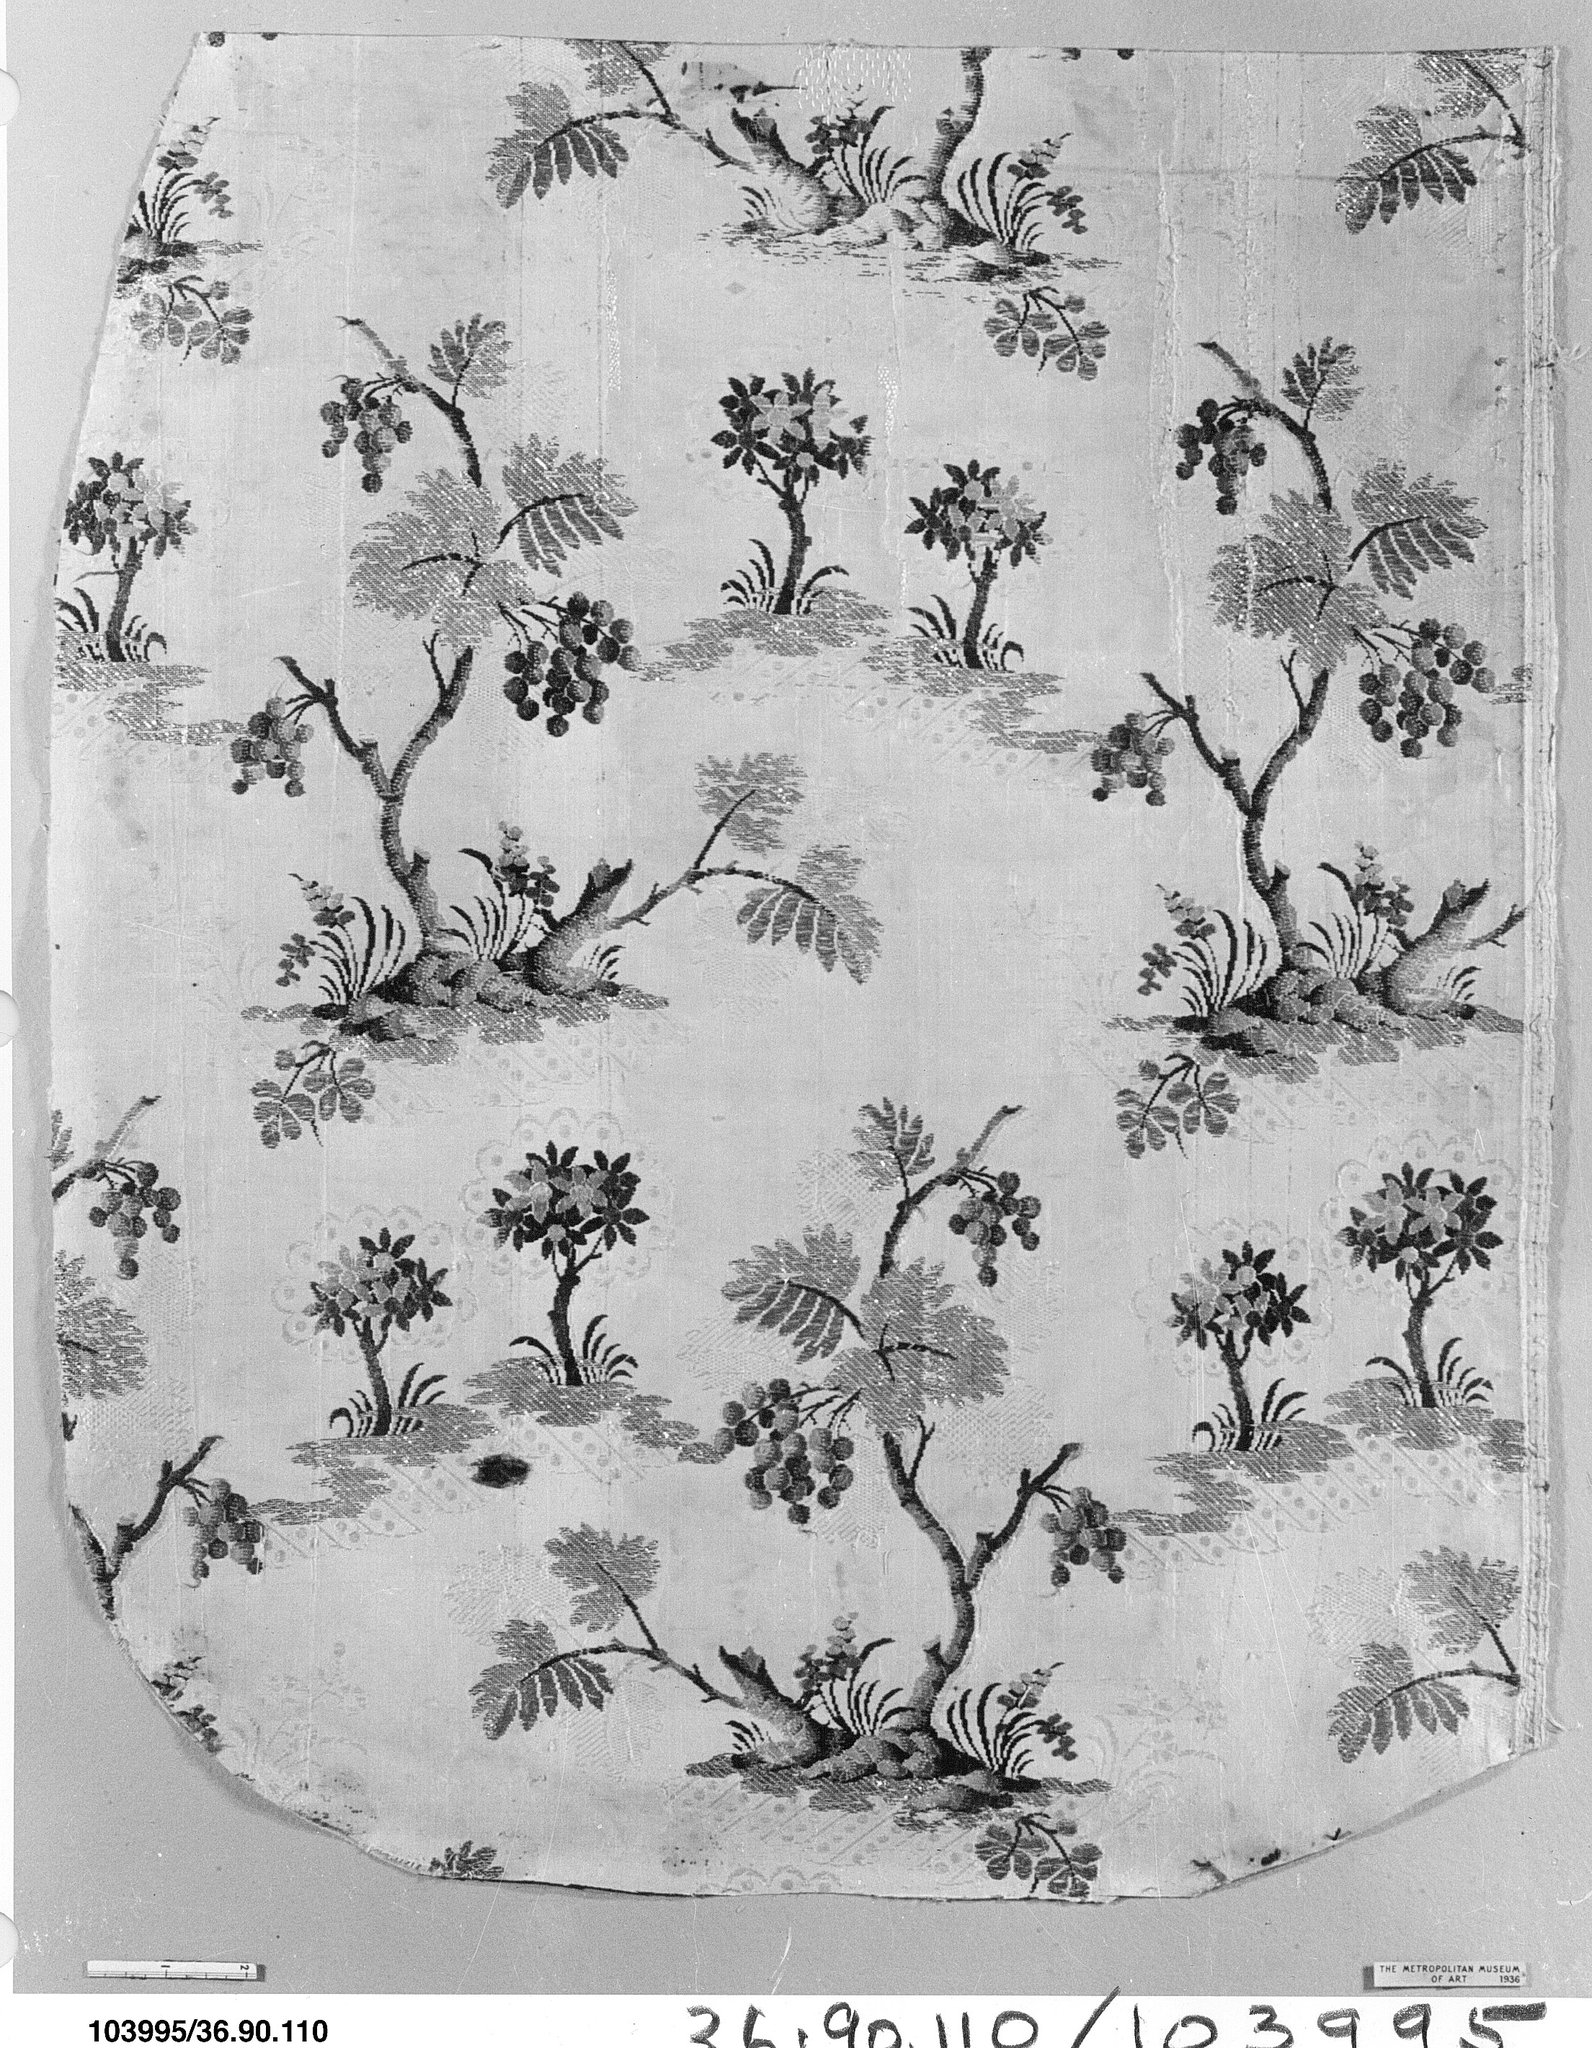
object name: piece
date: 1750-1760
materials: metal thread, silk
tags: fruit,trees